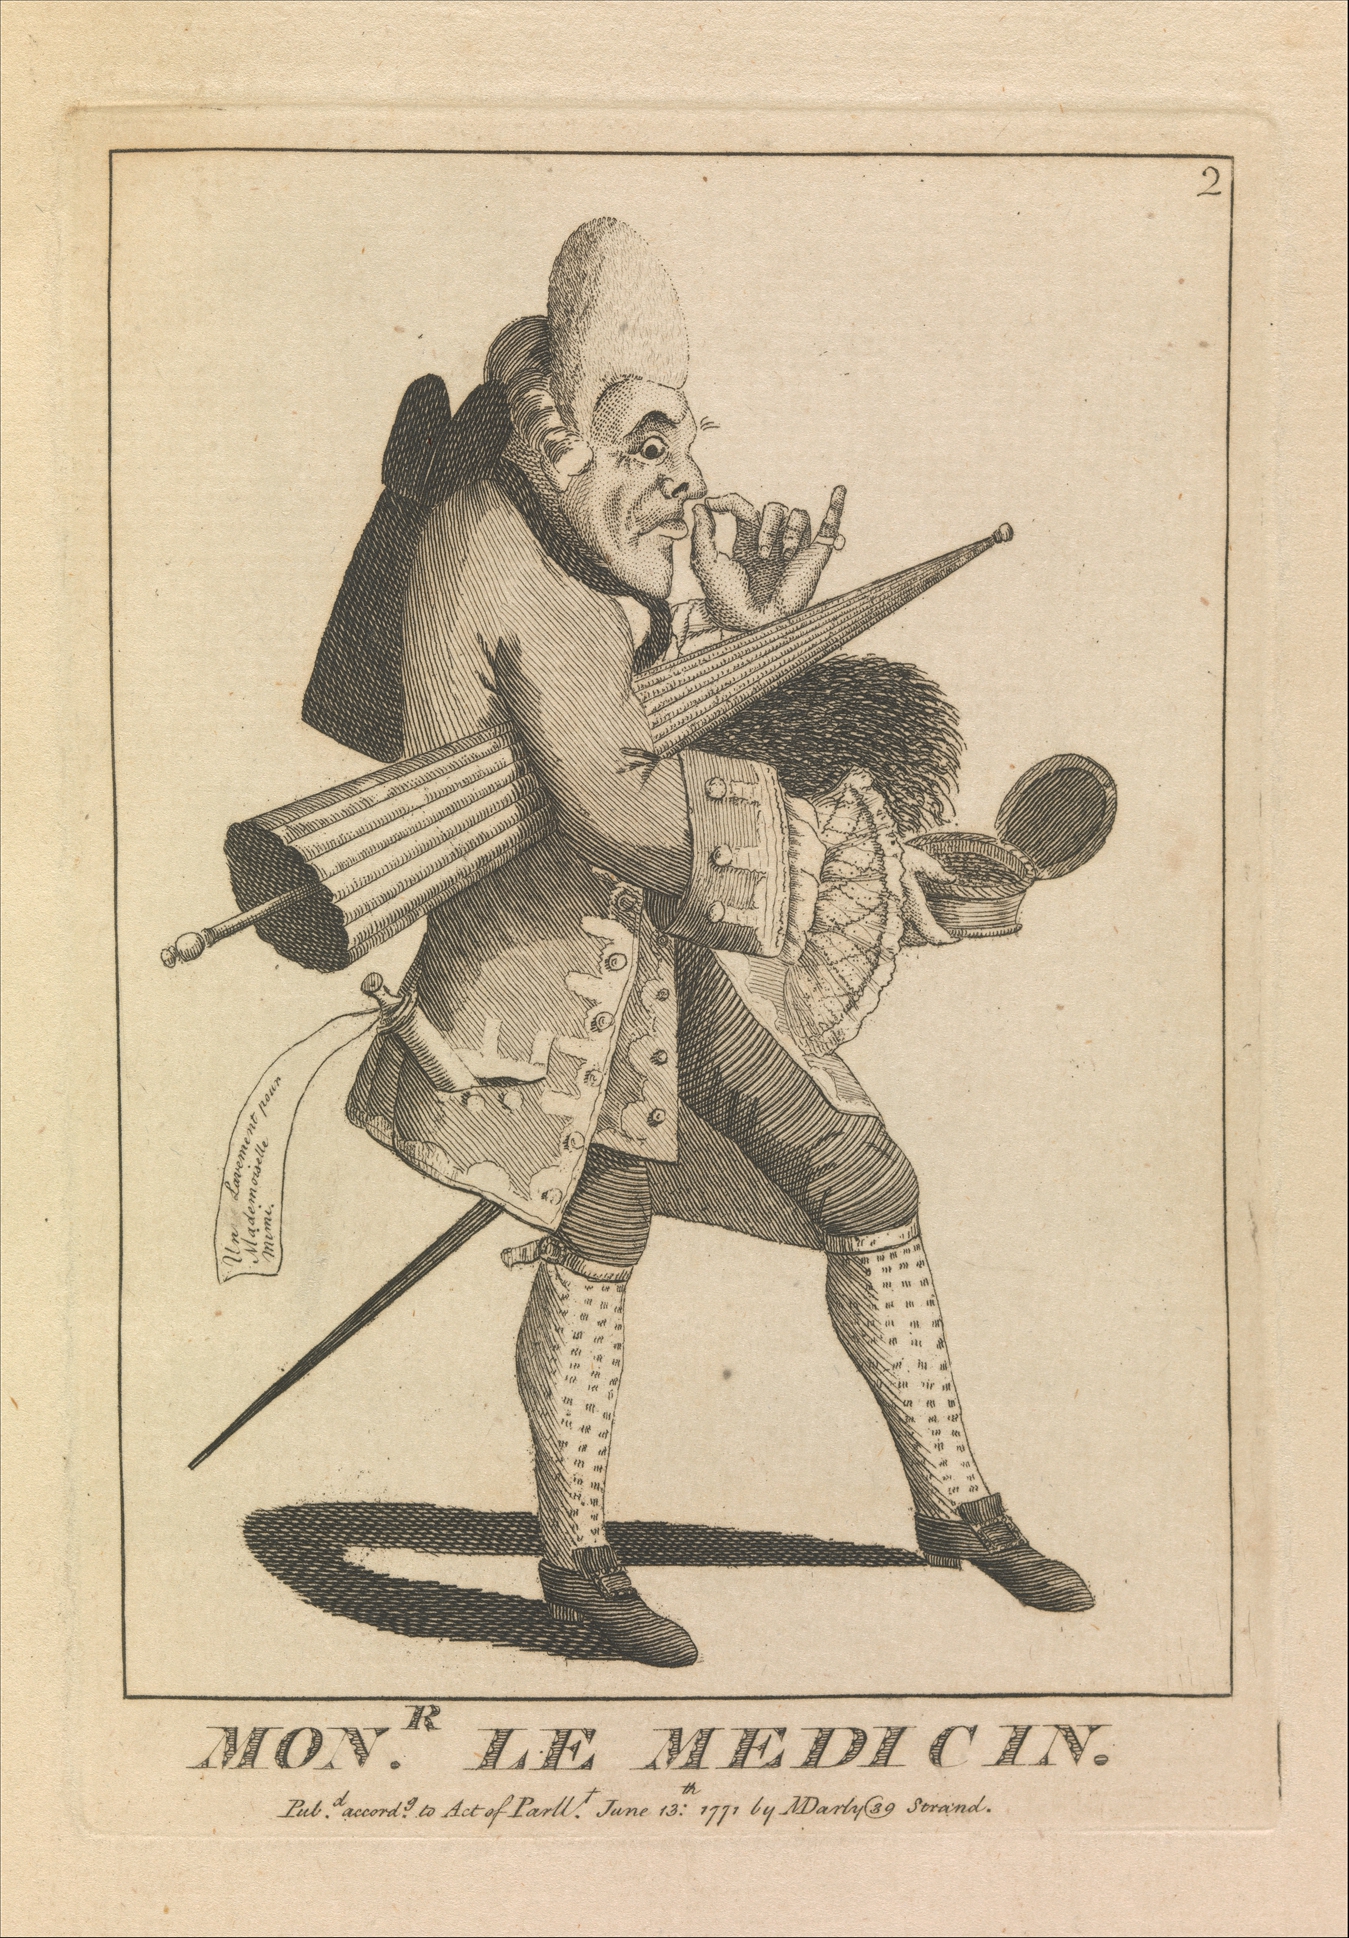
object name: print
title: Monsieur Le Medicin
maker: henry william bunbury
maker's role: artist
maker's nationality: british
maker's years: 1750-1811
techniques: etching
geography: london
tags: men